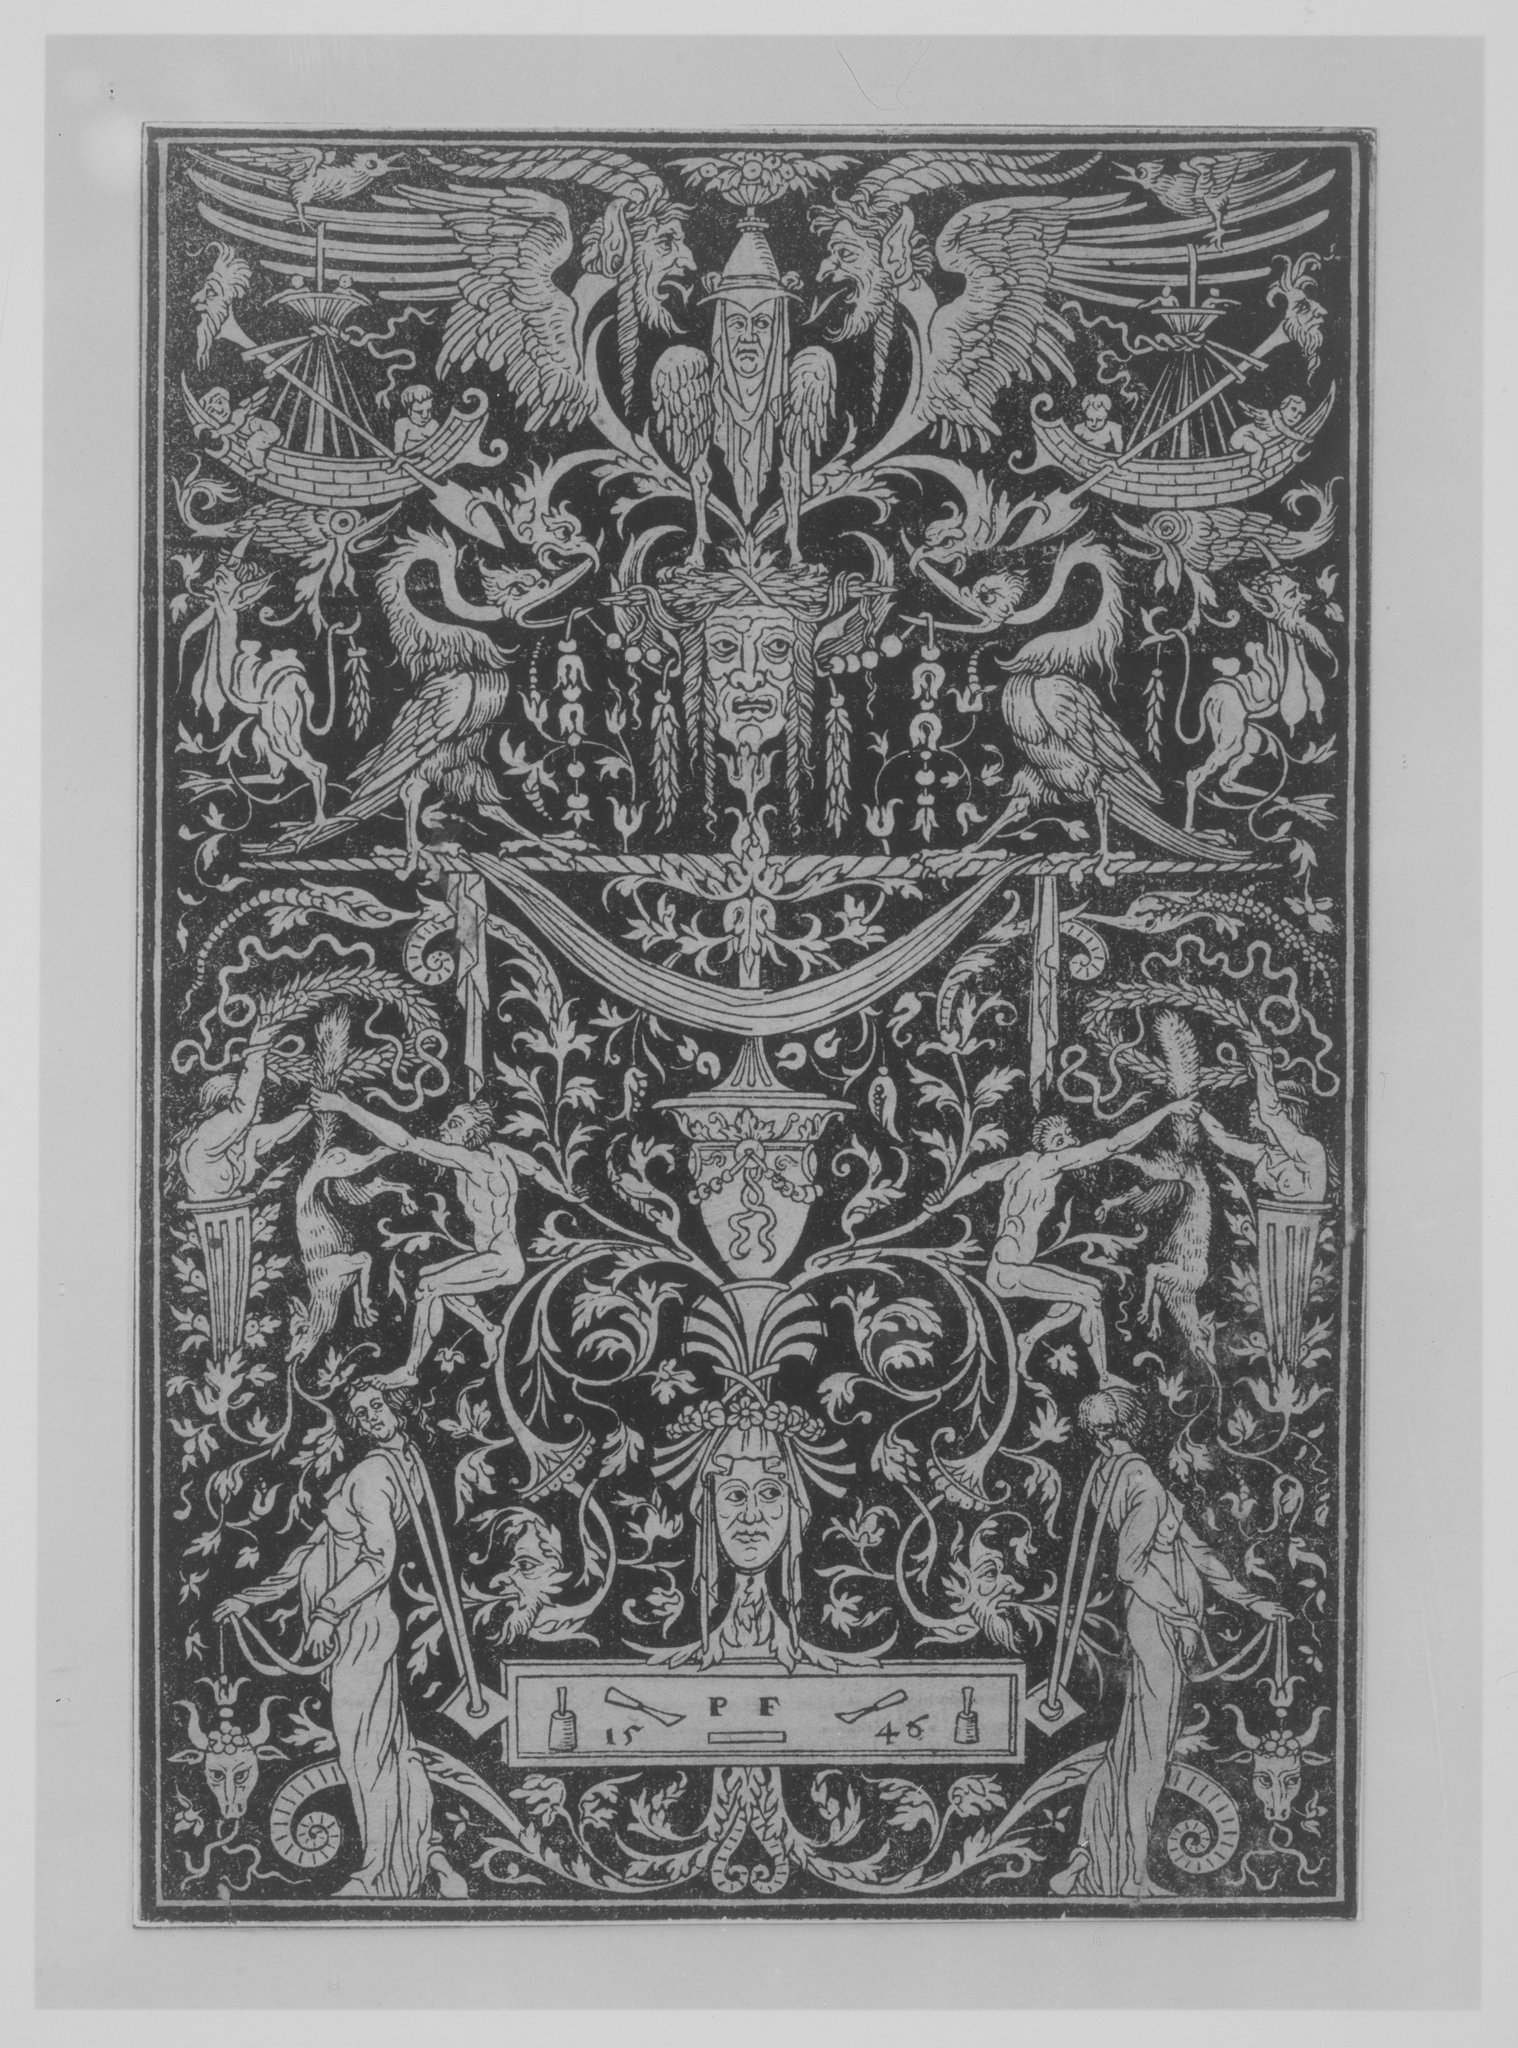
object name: print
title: Ornament Print Panel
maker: peter flötner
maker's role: artist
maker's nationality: german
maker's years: 1485-1546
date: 1501-1533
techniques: woodcut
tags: ornament